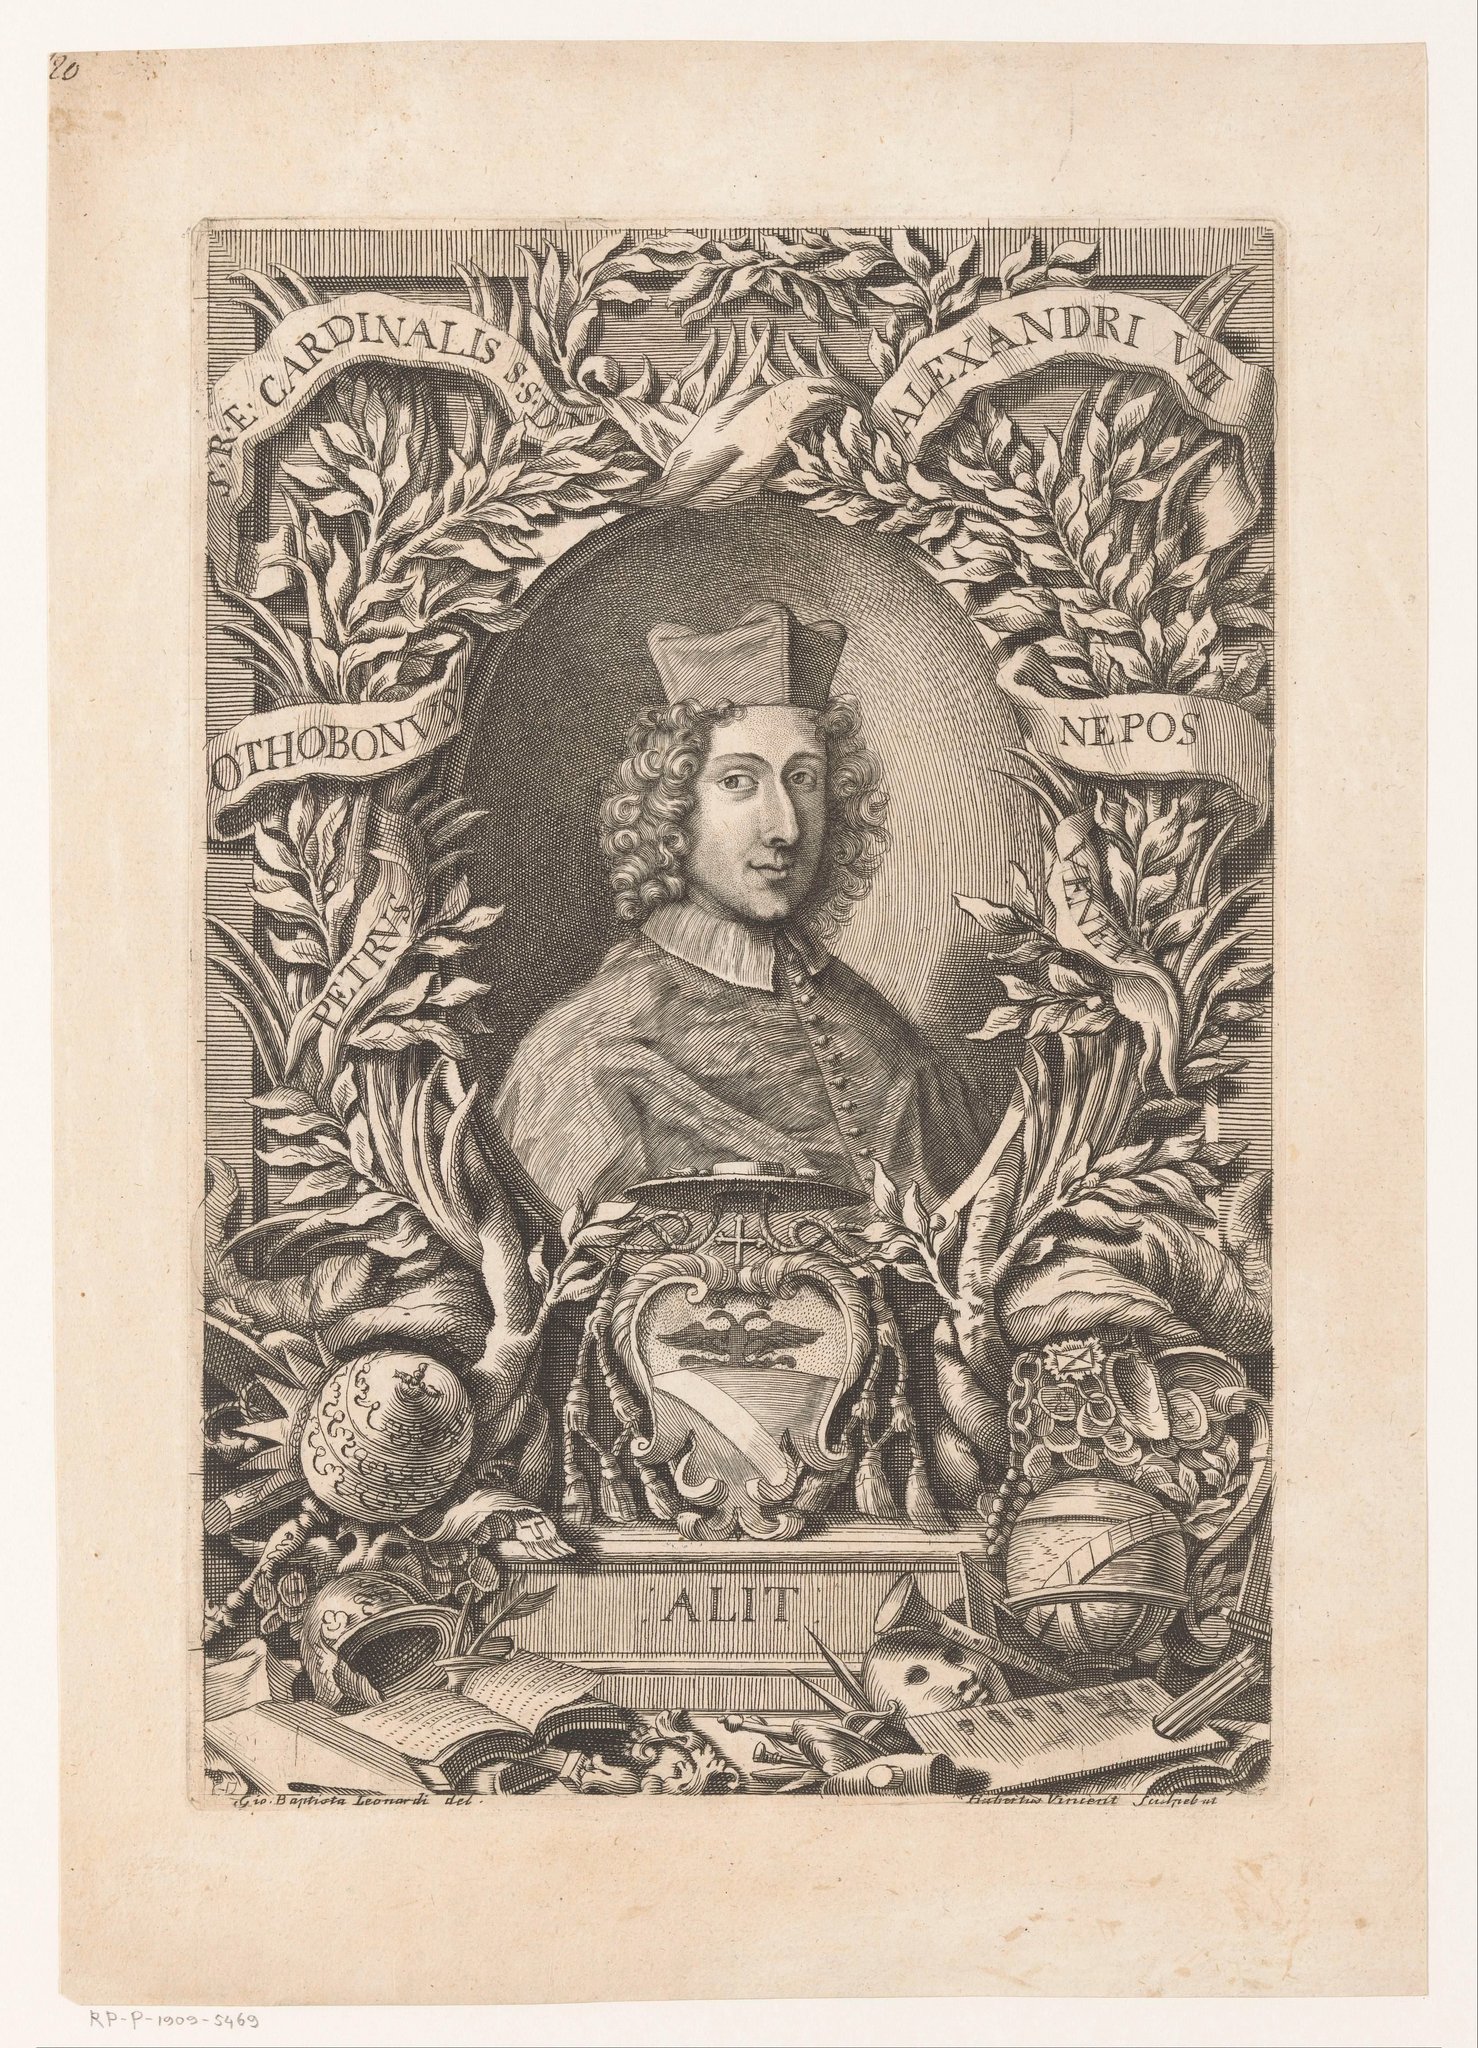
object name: print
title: Portret van kardinaal Pietro Vito Ottoboni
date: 1680-1730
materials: paper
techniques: engraving, etching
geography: rome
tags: venice, clergyman, alexander viii, the liberal arts together with other disciplines, cardinal, historical persons, pope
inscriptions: number: ‘20’, collector's mark: Lugt 2228